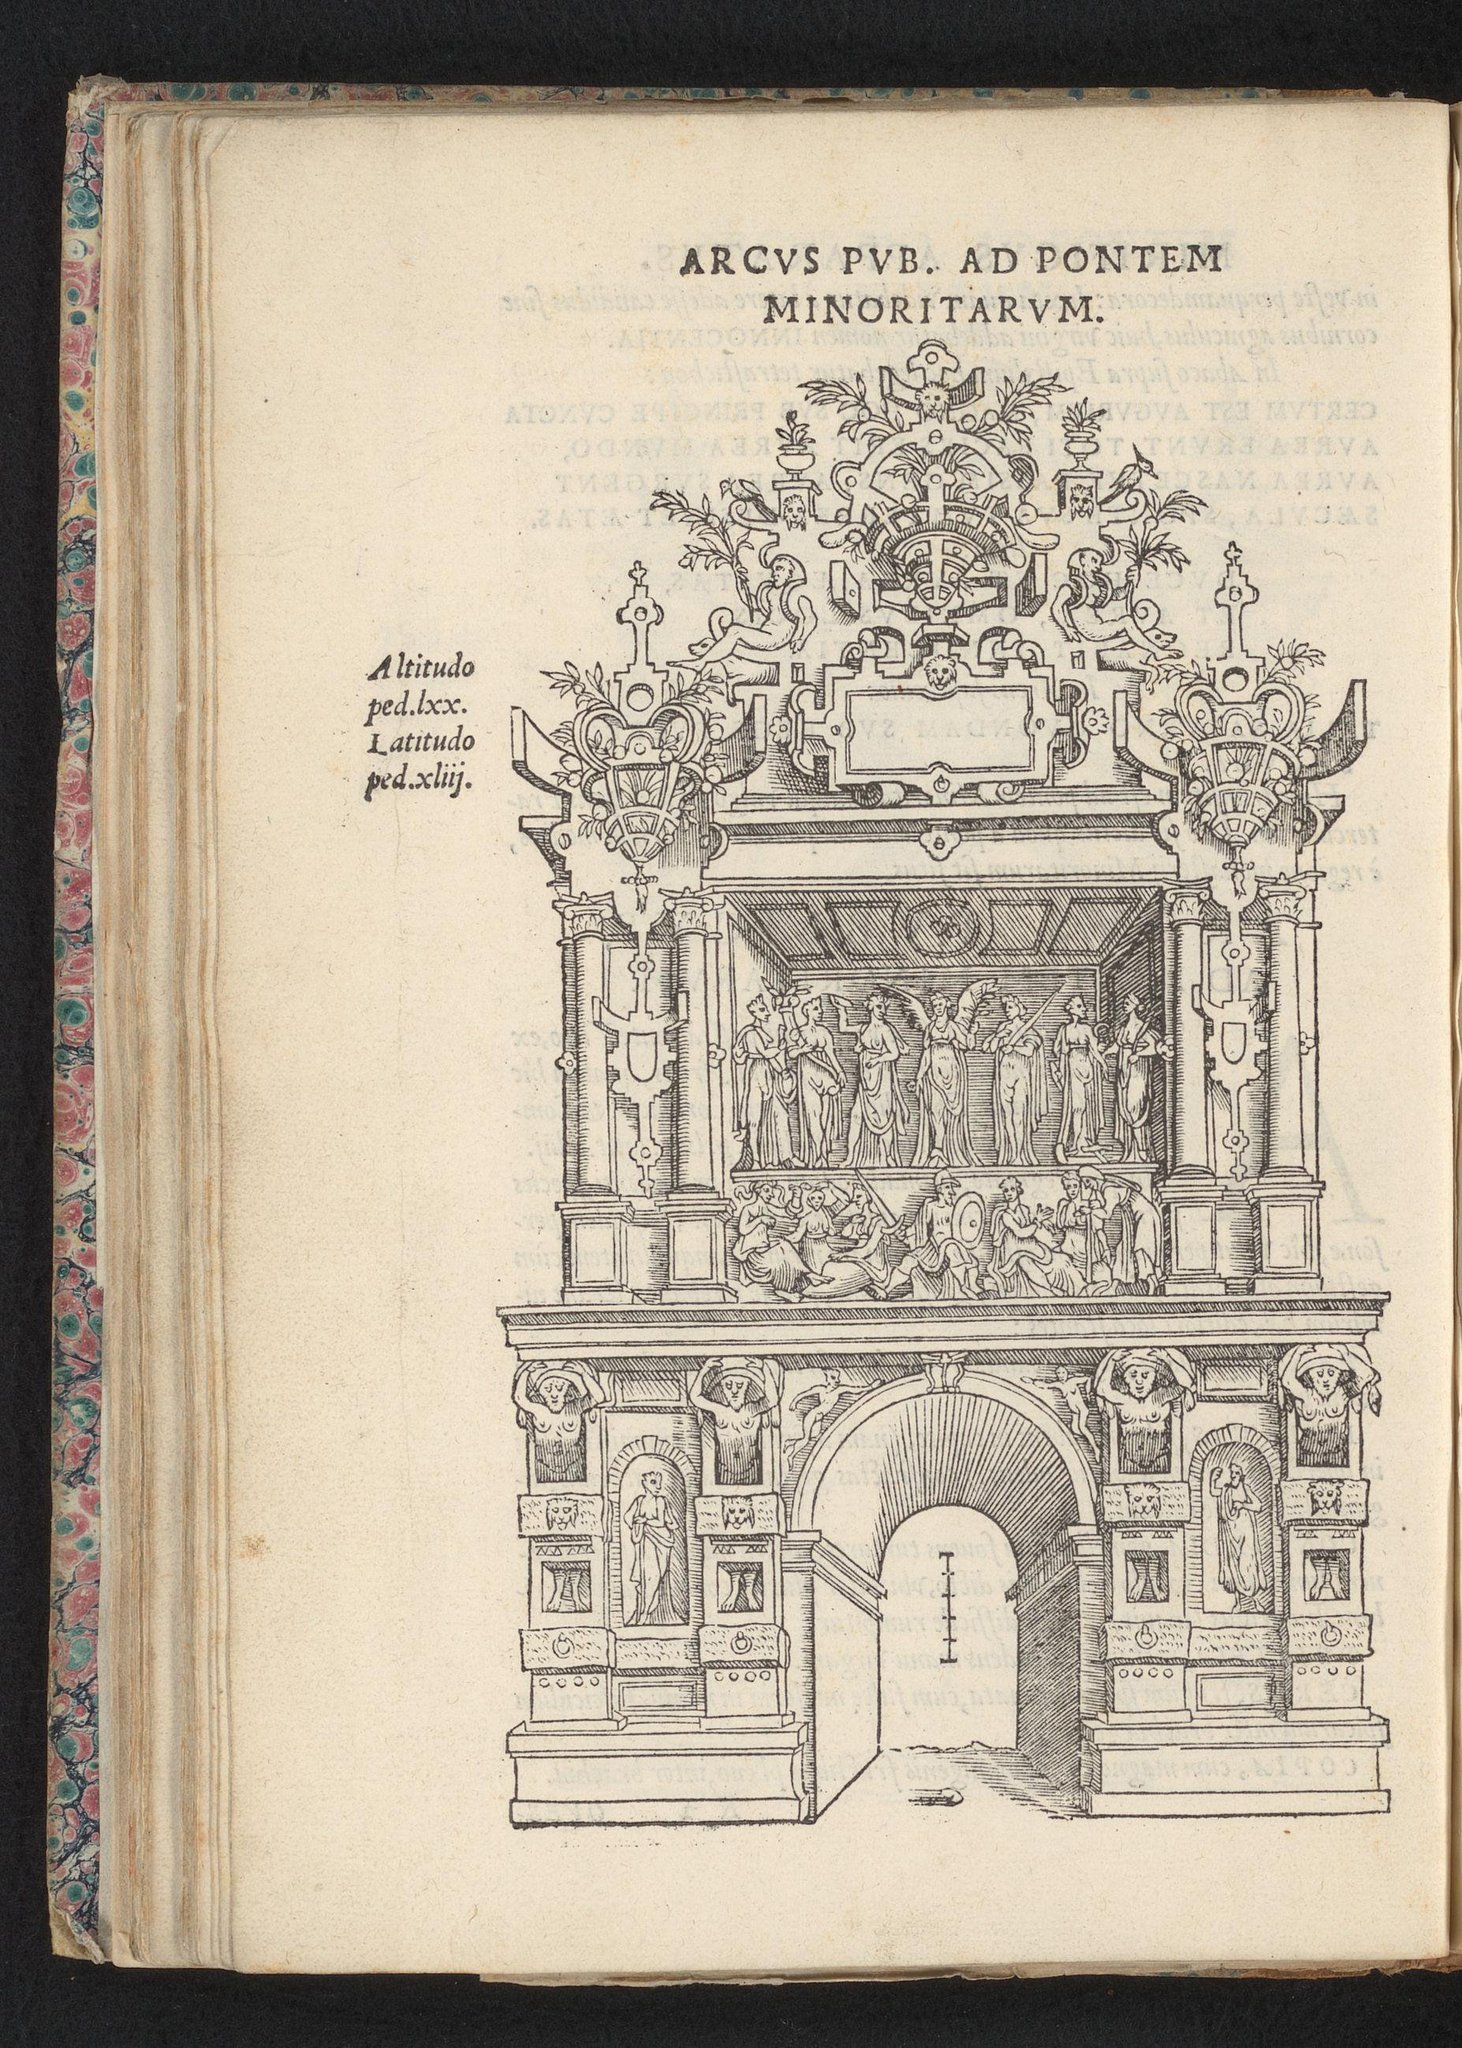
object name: print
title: De triomfboog van de stad aan de Minderbroedersbrug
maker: pieter coecke van aelst (i)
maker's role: draughtsman, print maker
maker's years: 1502-1550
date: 1549-1550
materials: paper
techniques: woodcut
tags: philip ii of spain, 'tableau vivant', triumphal arch, antwerp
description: Illustratie in: Spectaculorum in susceptione Philippi Hisp. Prin. Divi Caroli. V. Caes. F. ann 1549 Antverpiae aeditorum, mirificus apparatus. Tekst van Cornelius Grapheus, opgedragen aan Filips II, uitgegeven met keizerlijke privilege door Pieter Coecke van Aelst, gedrukt door Gillis van Diest. Boek in de bibliotheek met signatuur: 325 B 13.